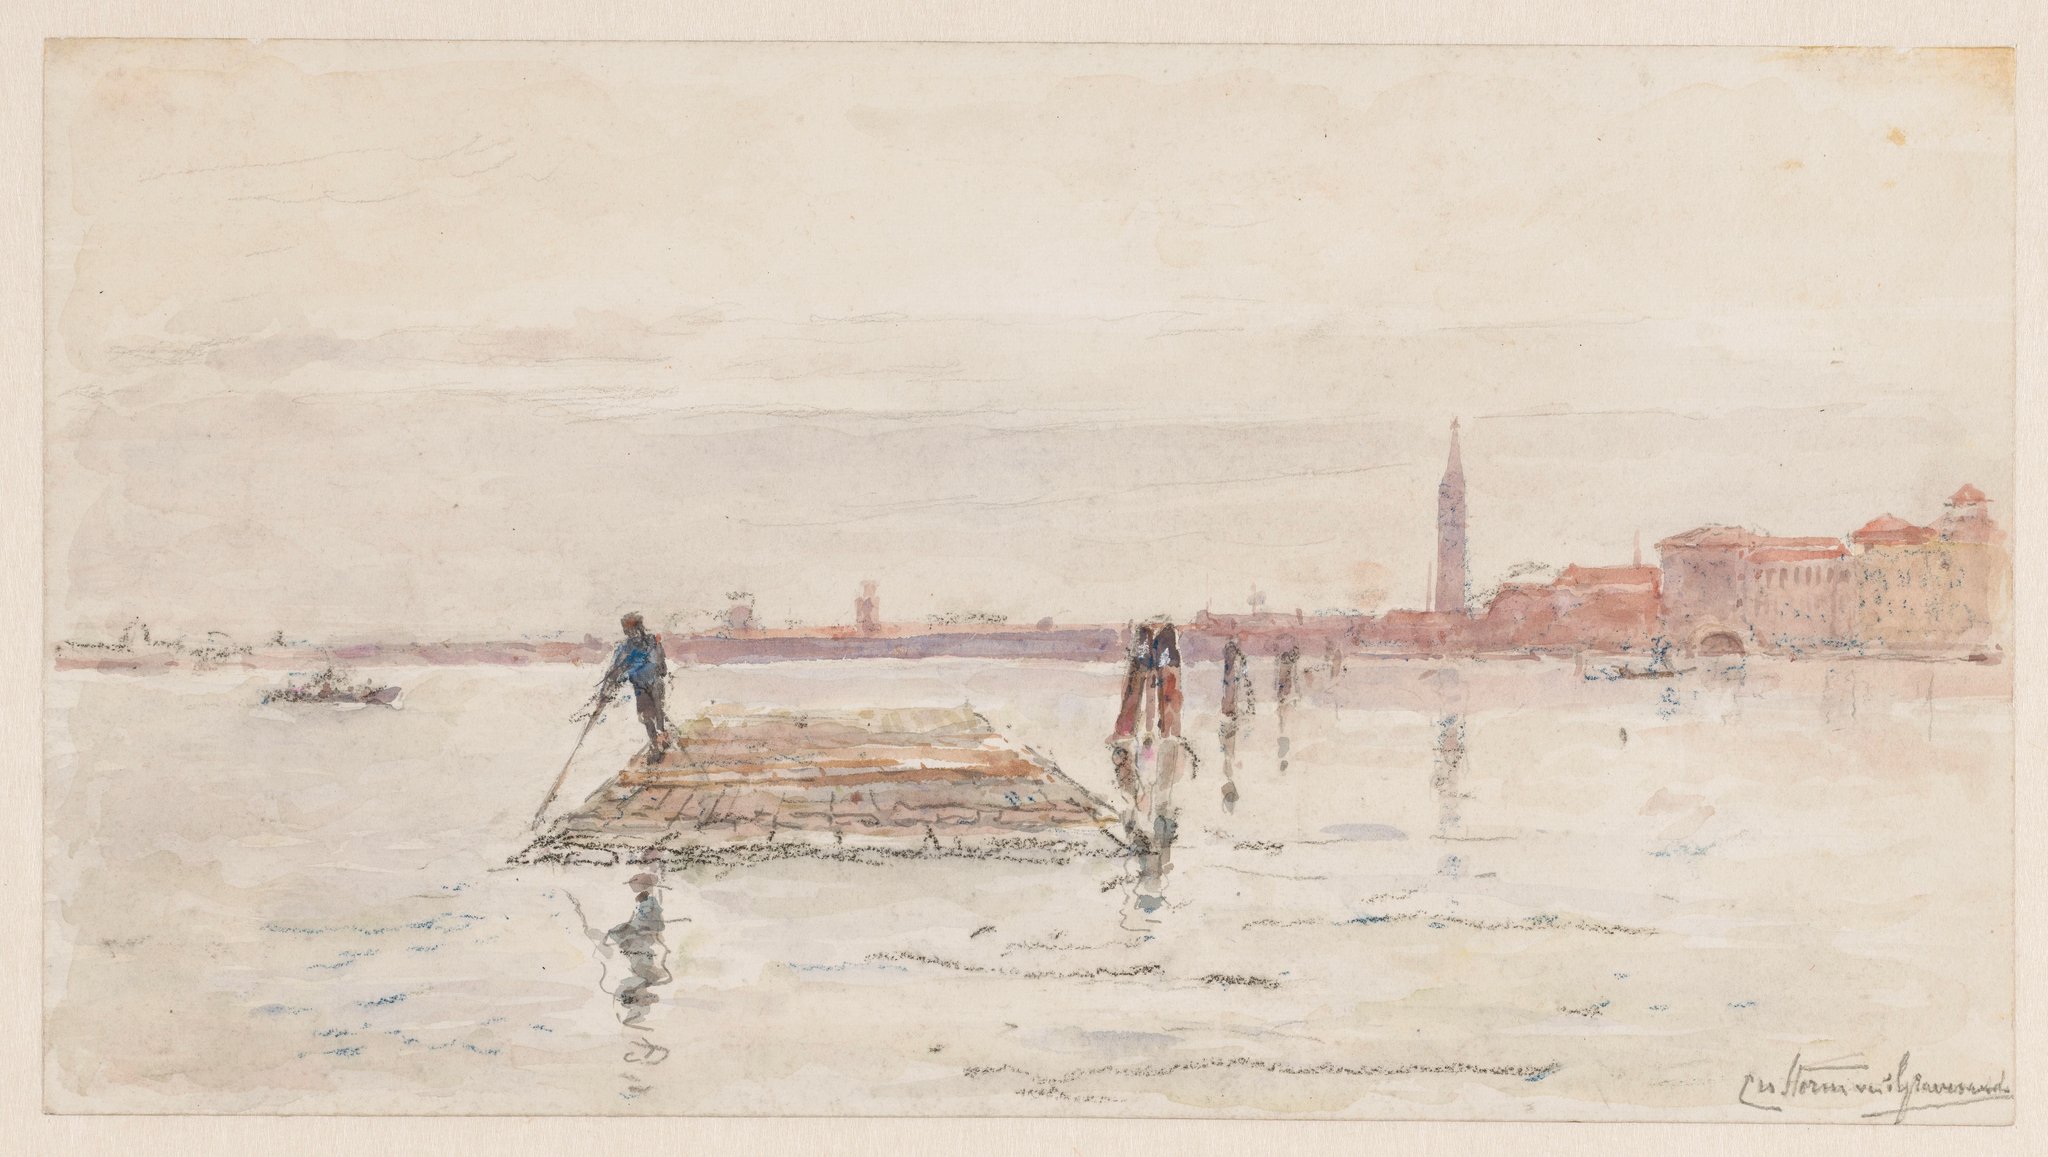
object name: drawing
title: Gezicht op Venetië vanaf het water, met op de voorgrond in het water een houten vlot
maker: carel nicolaas storm van s-gravesande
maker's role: draughtsman, print maker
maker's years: 1841-1924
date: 1888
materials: chalk, paper, pencil, watercolor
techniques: brush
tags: improvised and unusual traffic on the water, city-view in general; 'veduta', italy, venice